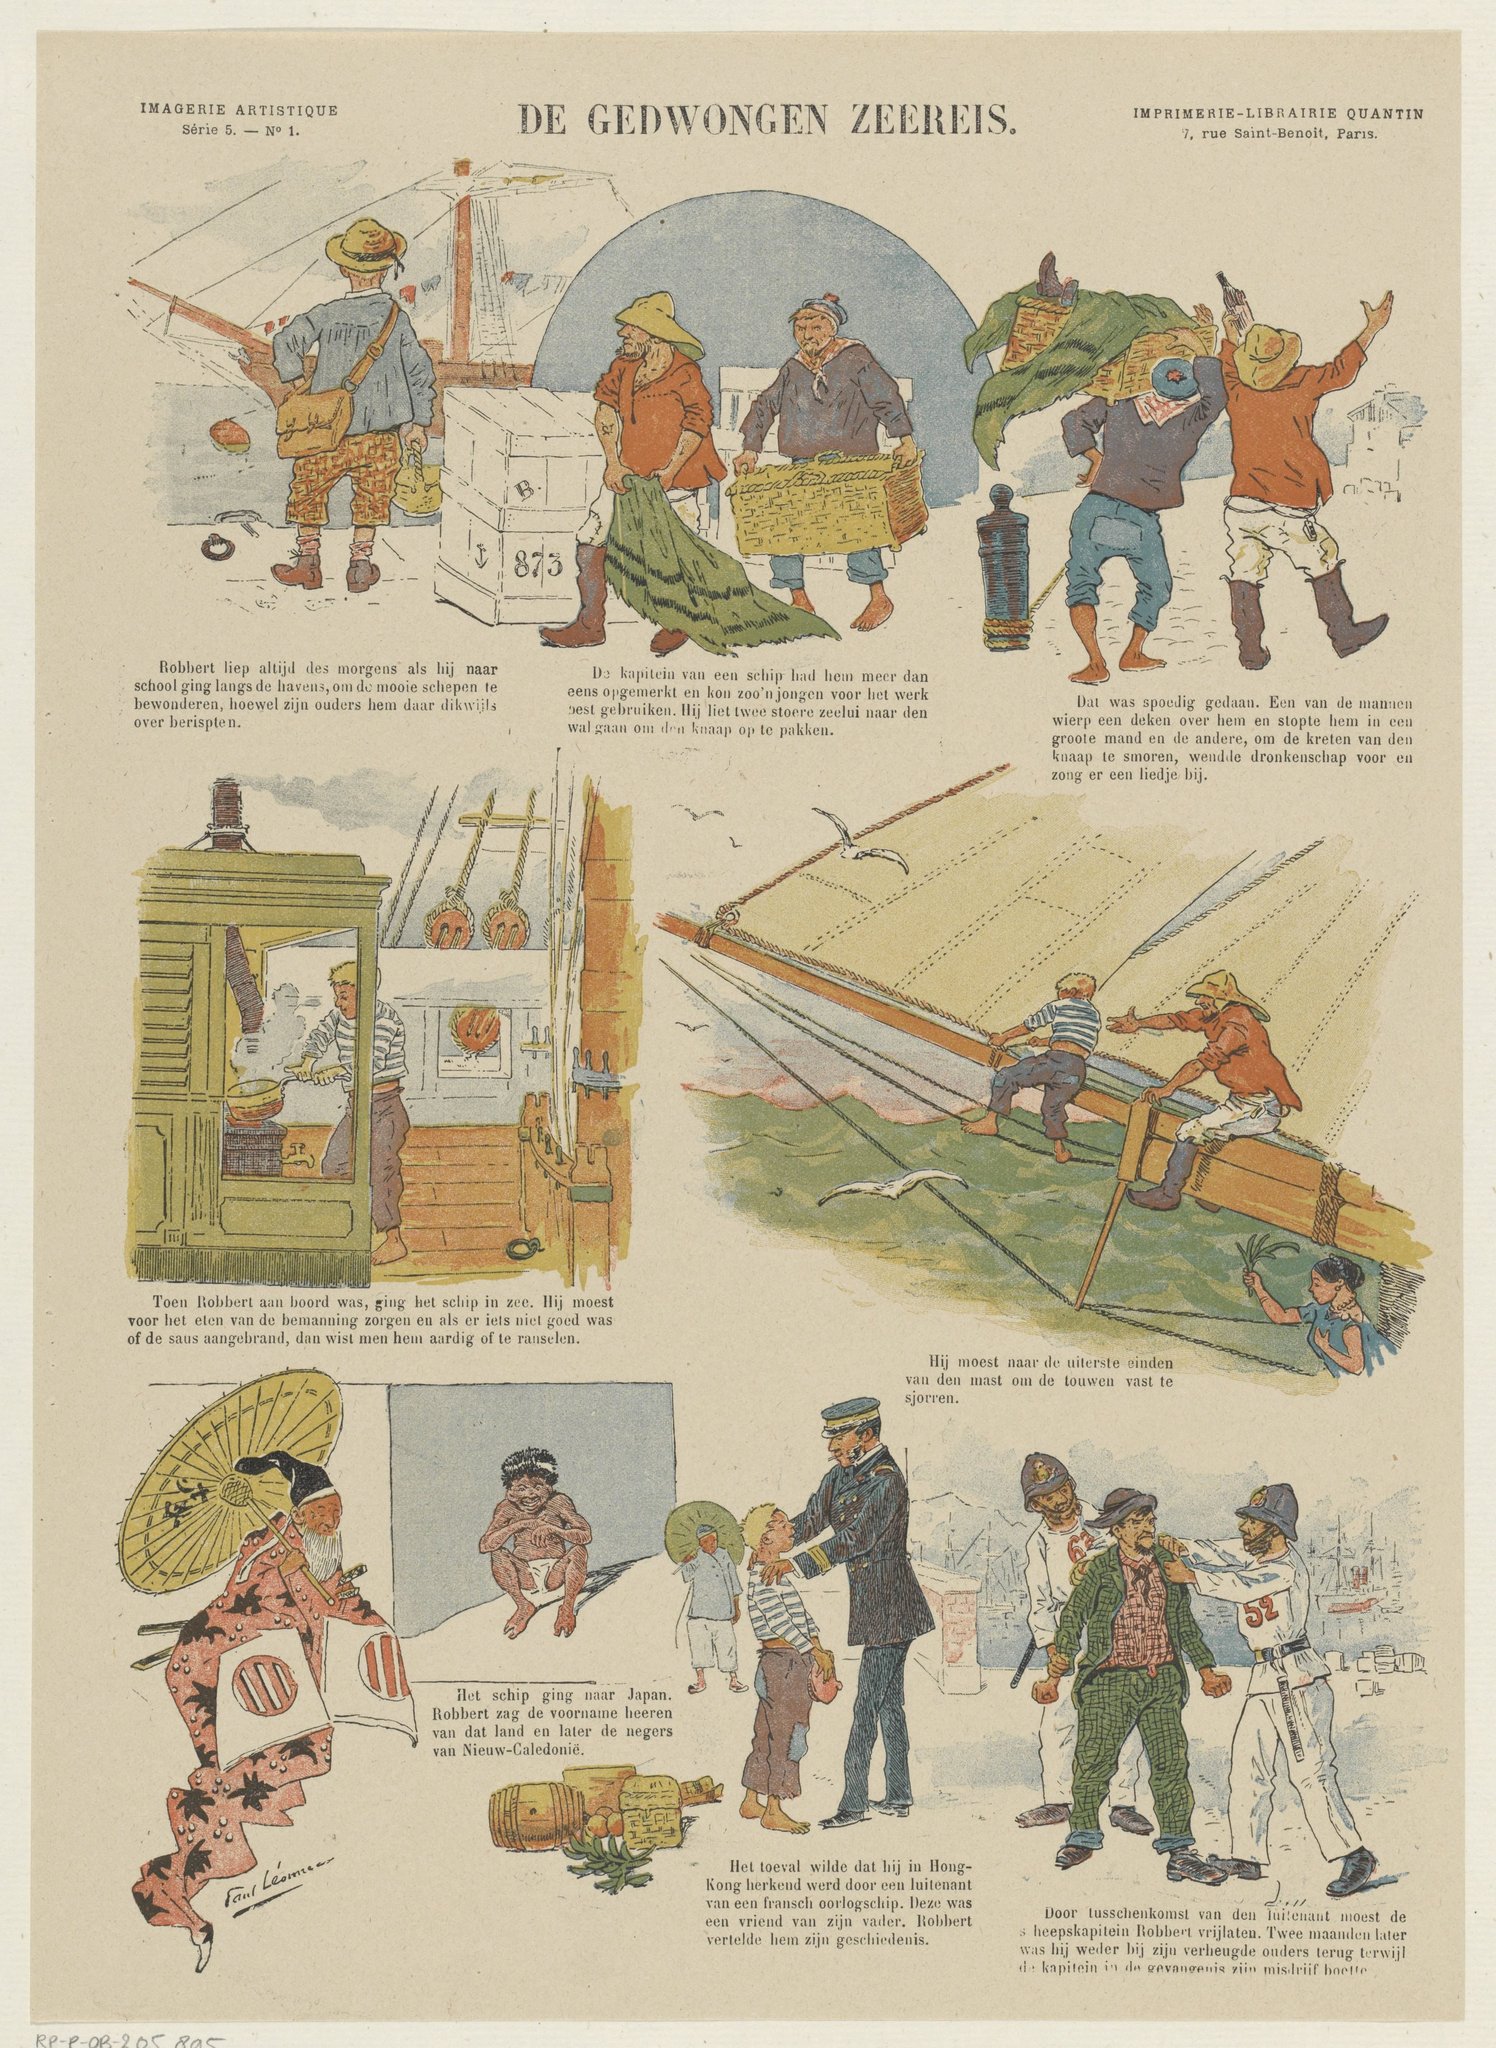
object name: popular print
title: Imagerie Artistique / Série 5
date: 1876-1890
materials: paper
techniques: lithograph, letterpress printing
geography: paris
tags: tales and fairy tales, arrest (of criminal), seaman: sailor, kidnapping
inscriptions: collector's mark: Lugt 2760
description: Blad met 3 rijen met voorstellingen uit het verhaal van het jongetje Robert dat wordt ontvoerd door zeelieden. Onder elke voorstelling een onderschrift. Genummerd linksboven: Série 5. - No. 1.